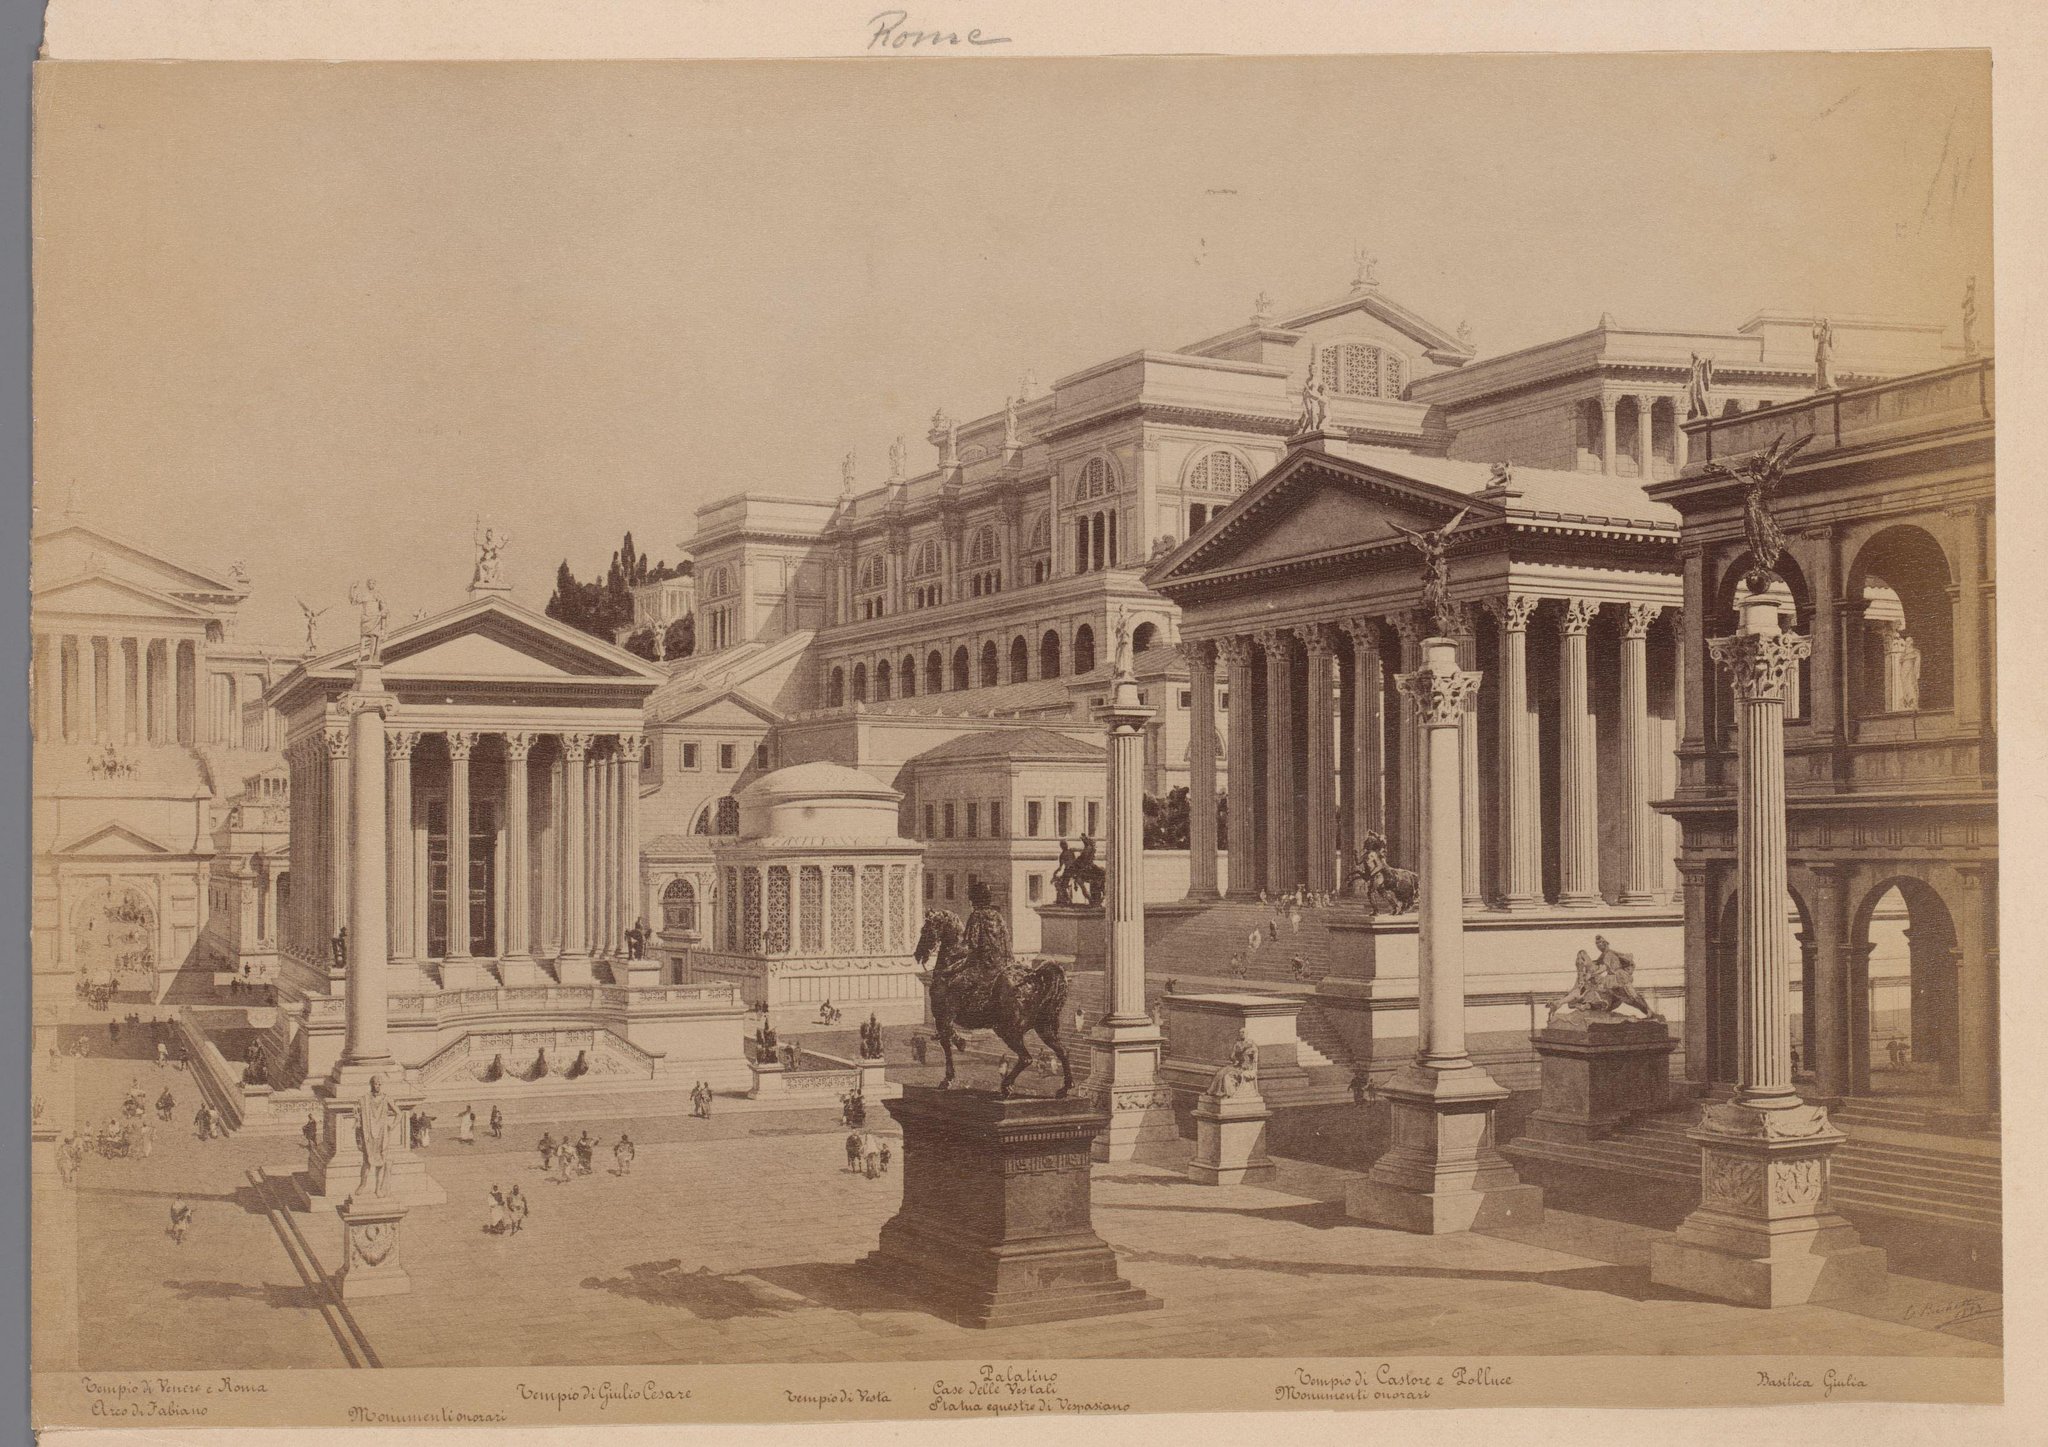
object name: photograph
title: Reproductie van een tekening van E. Burketti uit 1893 waarin een deel van het Forum Romanum wordt gereconstrueerd, Piazza del Foro Romano, Italië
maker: Anonymous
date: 1893-1910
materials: cardboard, photographic support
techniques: albumen print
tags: rome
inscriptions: signature and date: ‘E. Burketti 1893’, inscription: ‘Rome’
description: Reproductie van een tekening van E. Burketti uit 1893 waarin het oude Rome (Forum Romanum) wordt gereconstrueerd: onderaan zijn de bijschriften te zien bij de oude gebouwen.